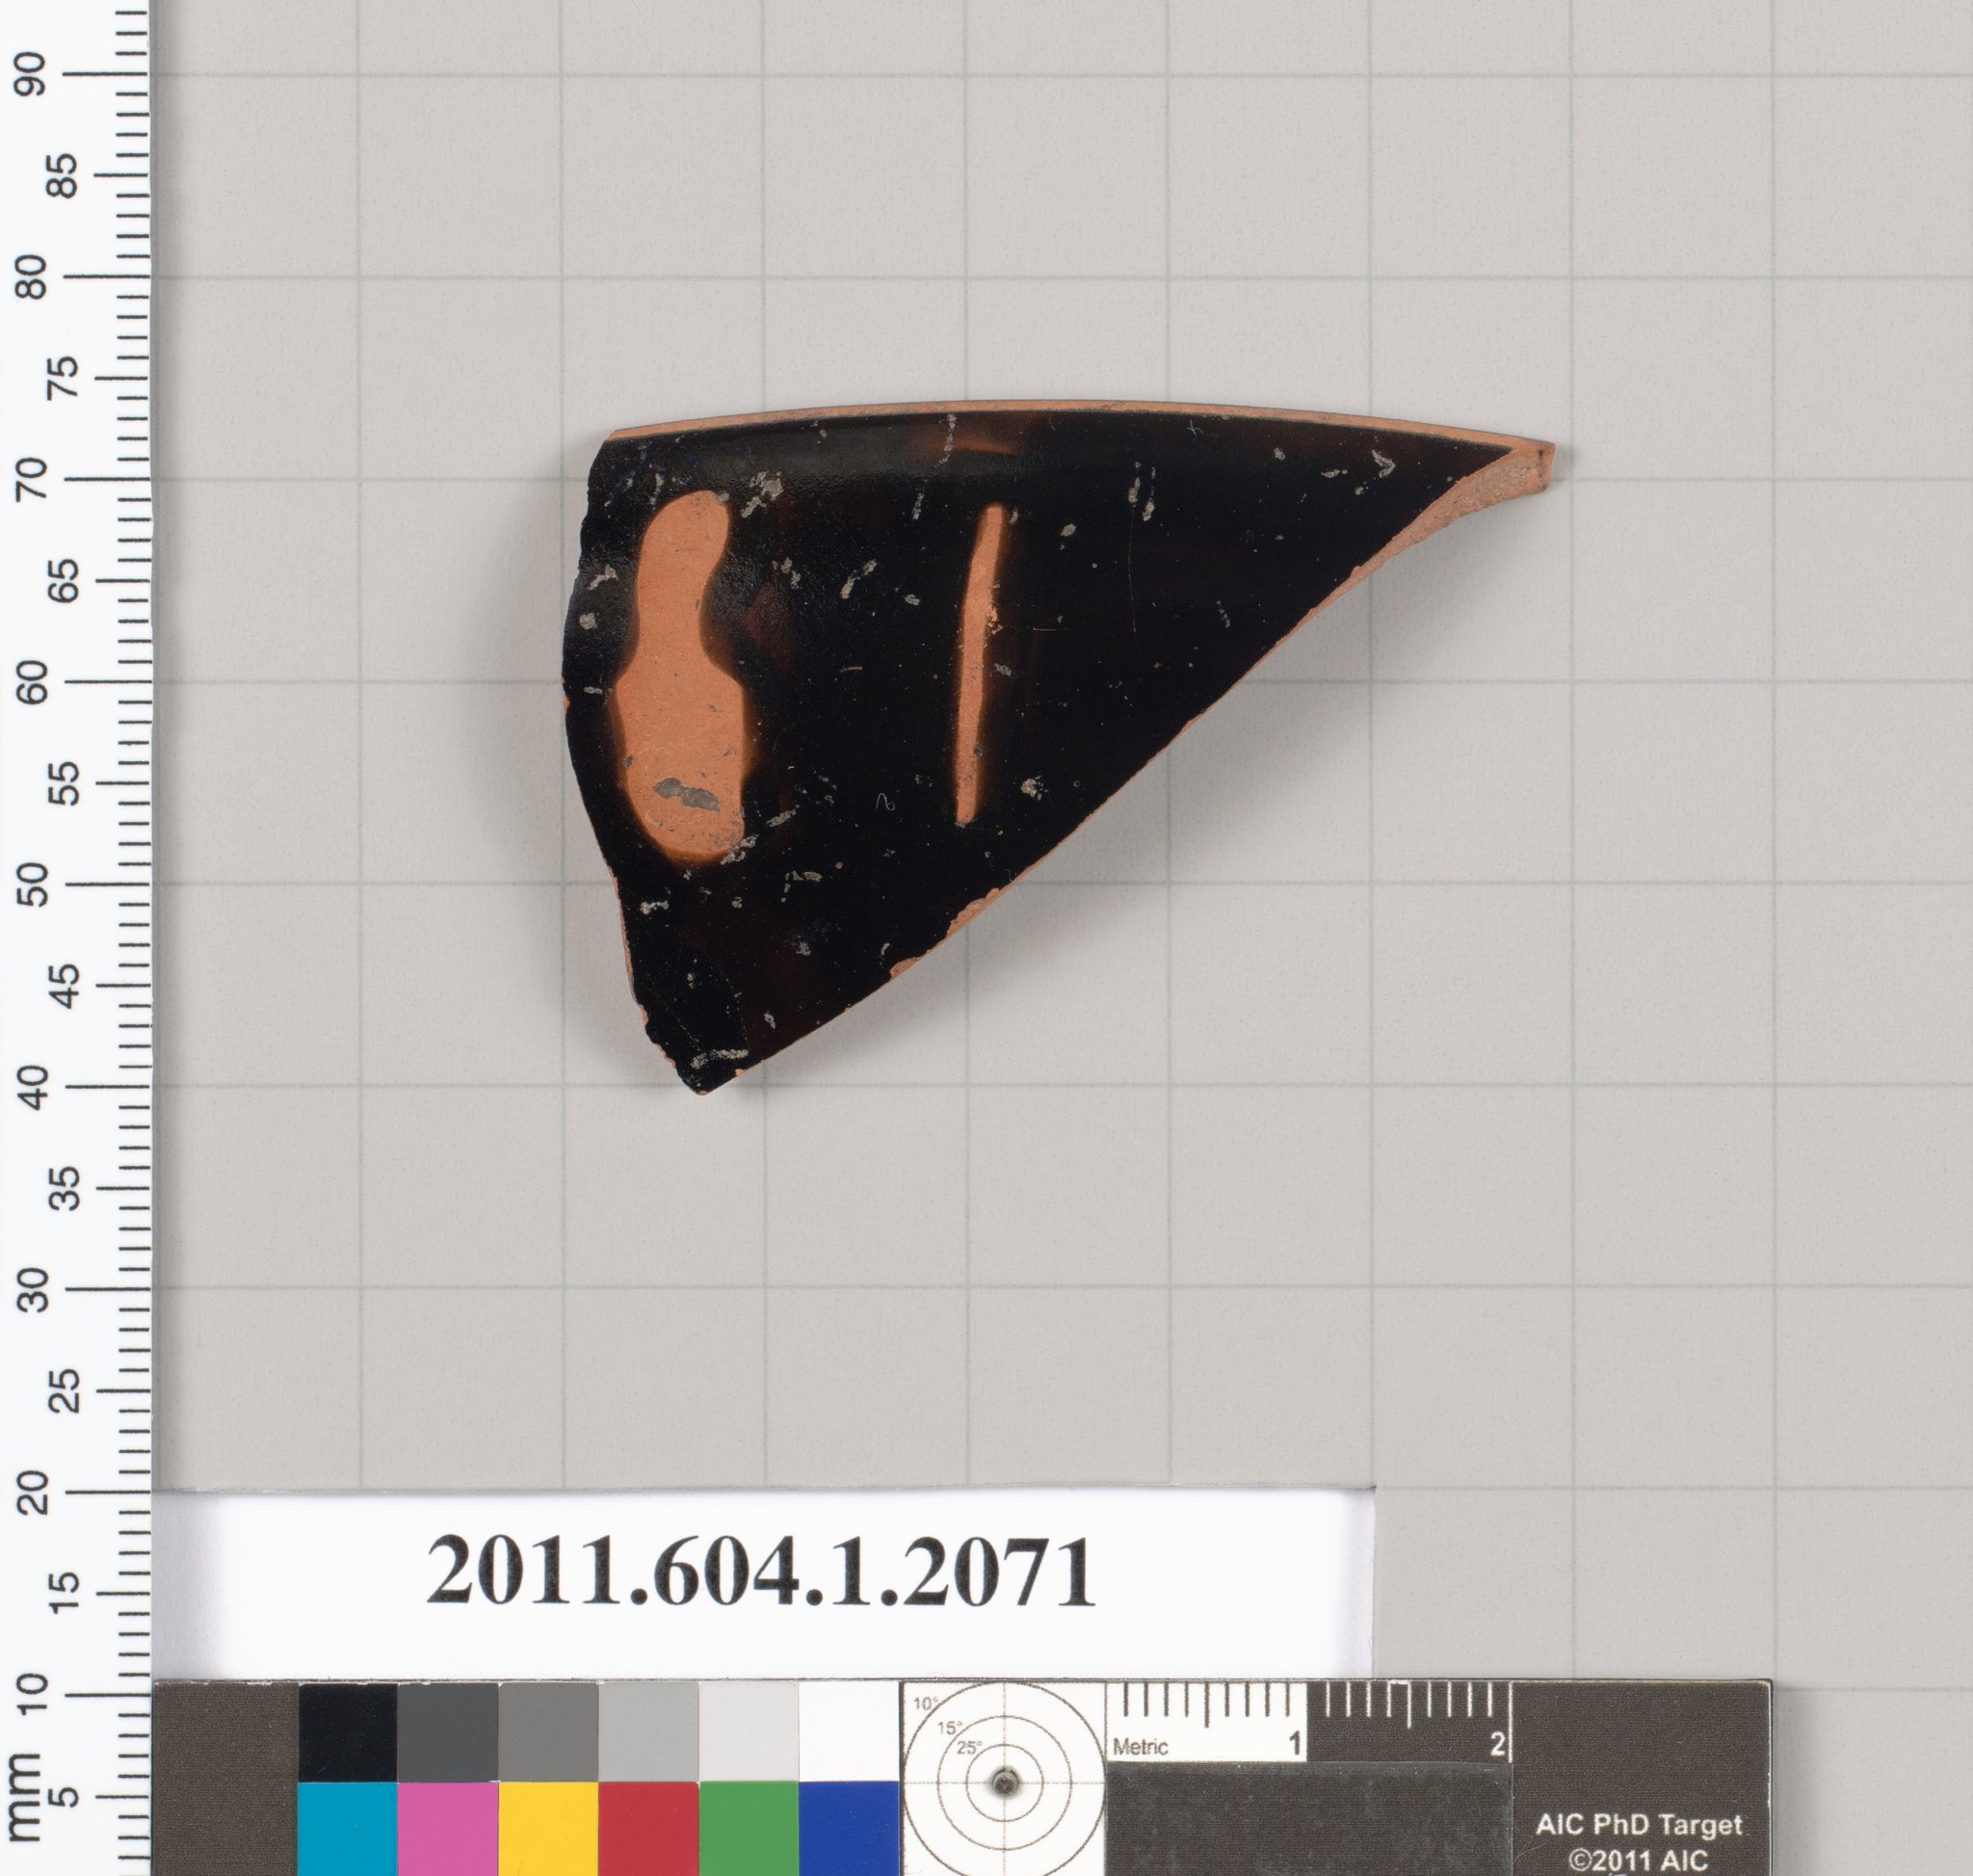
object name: kylix fragment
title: Terracotta rim fragment of a kylix (drinking cup)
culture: greek, attic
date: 475-451 BCE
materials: terracotta